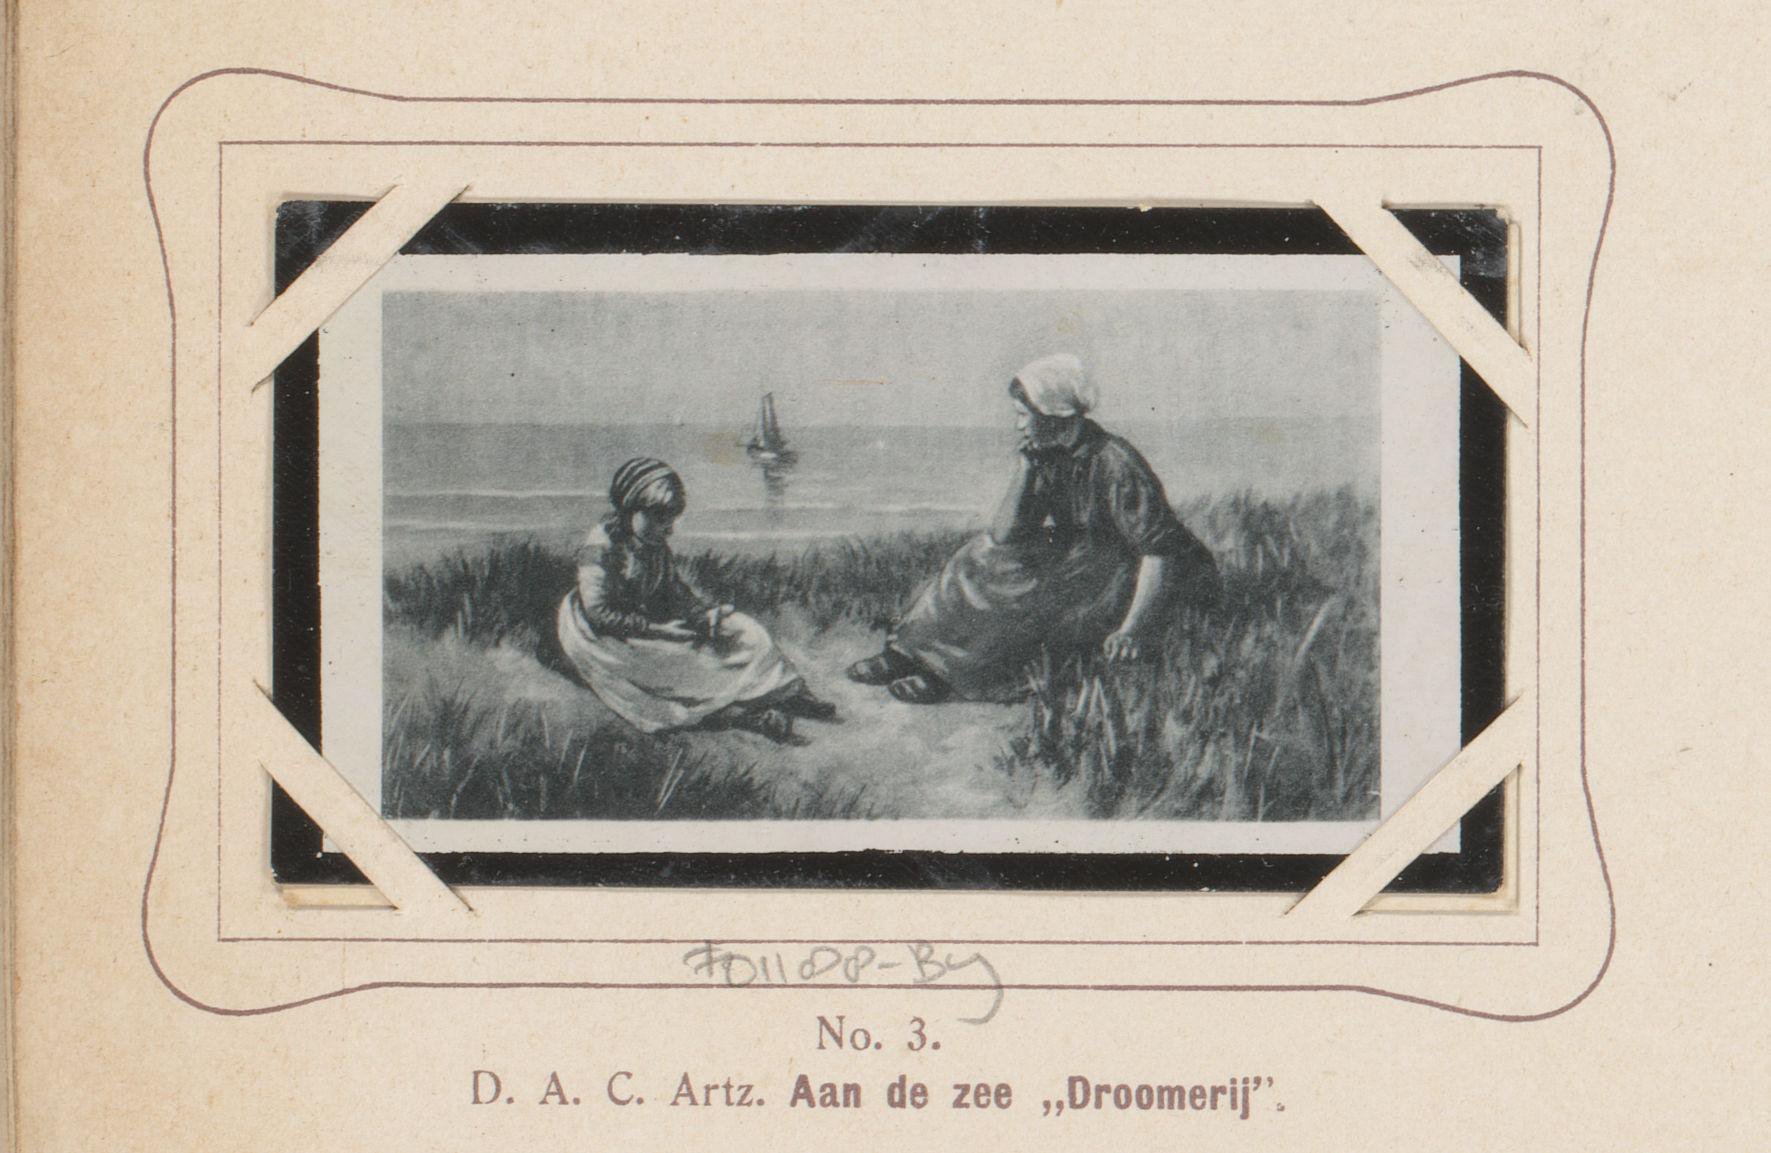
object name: album leaf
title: Reproductie van een schilderij van twee meisjes in de duinen naar David Adolph Constant Artz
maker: Anonymous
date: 1906-1907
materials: paper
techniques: photograph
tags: girl (child between toddler and youth), dune coast (+ landscape with figures, staffage)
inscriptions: inscription: ‘No. 3./ D.A.C. Artz. Aan de zee "Droomerij"’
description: Deze prent maakt deel uit van een album.